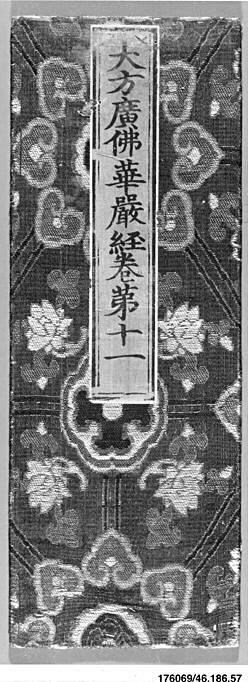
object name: sutra cover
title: Sutra Cover with Decorated Lattice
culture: chinese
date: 1401-1600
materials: metal thread, silk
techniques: patterning, weave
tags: flowers